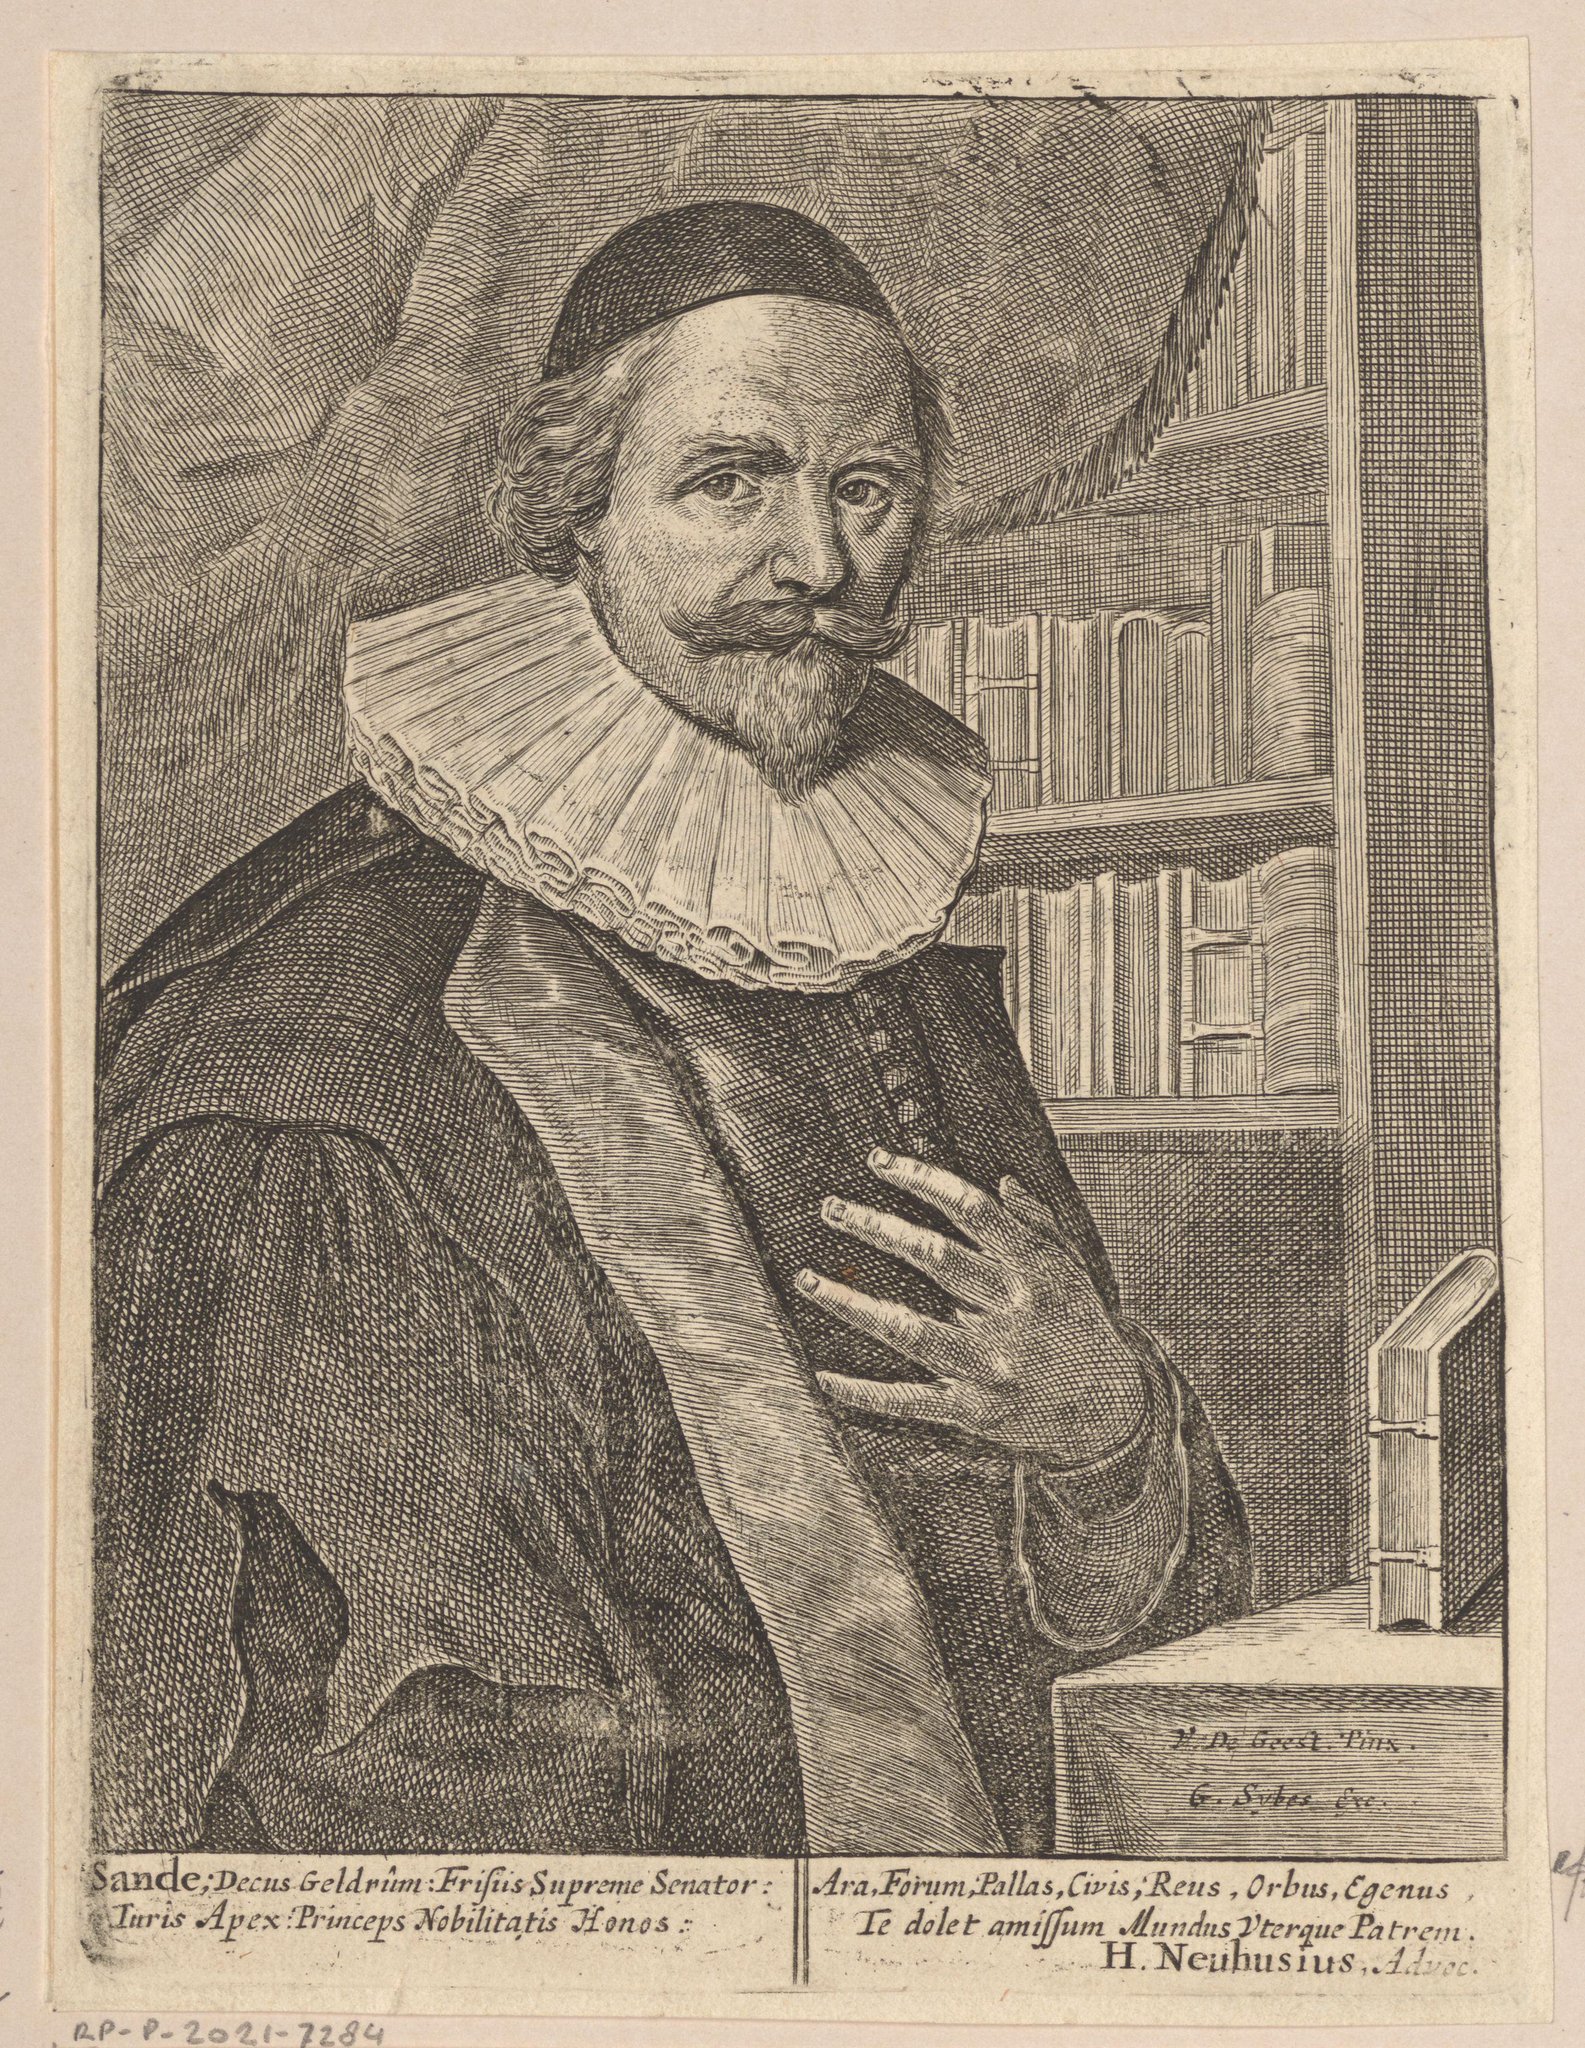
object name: book illustration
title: Portret van Johan van den Sande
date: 1683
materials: paper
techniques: engraving, letterpress printing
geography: groningen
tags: arnhem, johan van den sande, historical persons, portrait of a writer, book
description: Prent uit: Sande, Johan van den. Opera omnia juridica continentia (...). Groningen: Dominicus Lens, 1683.